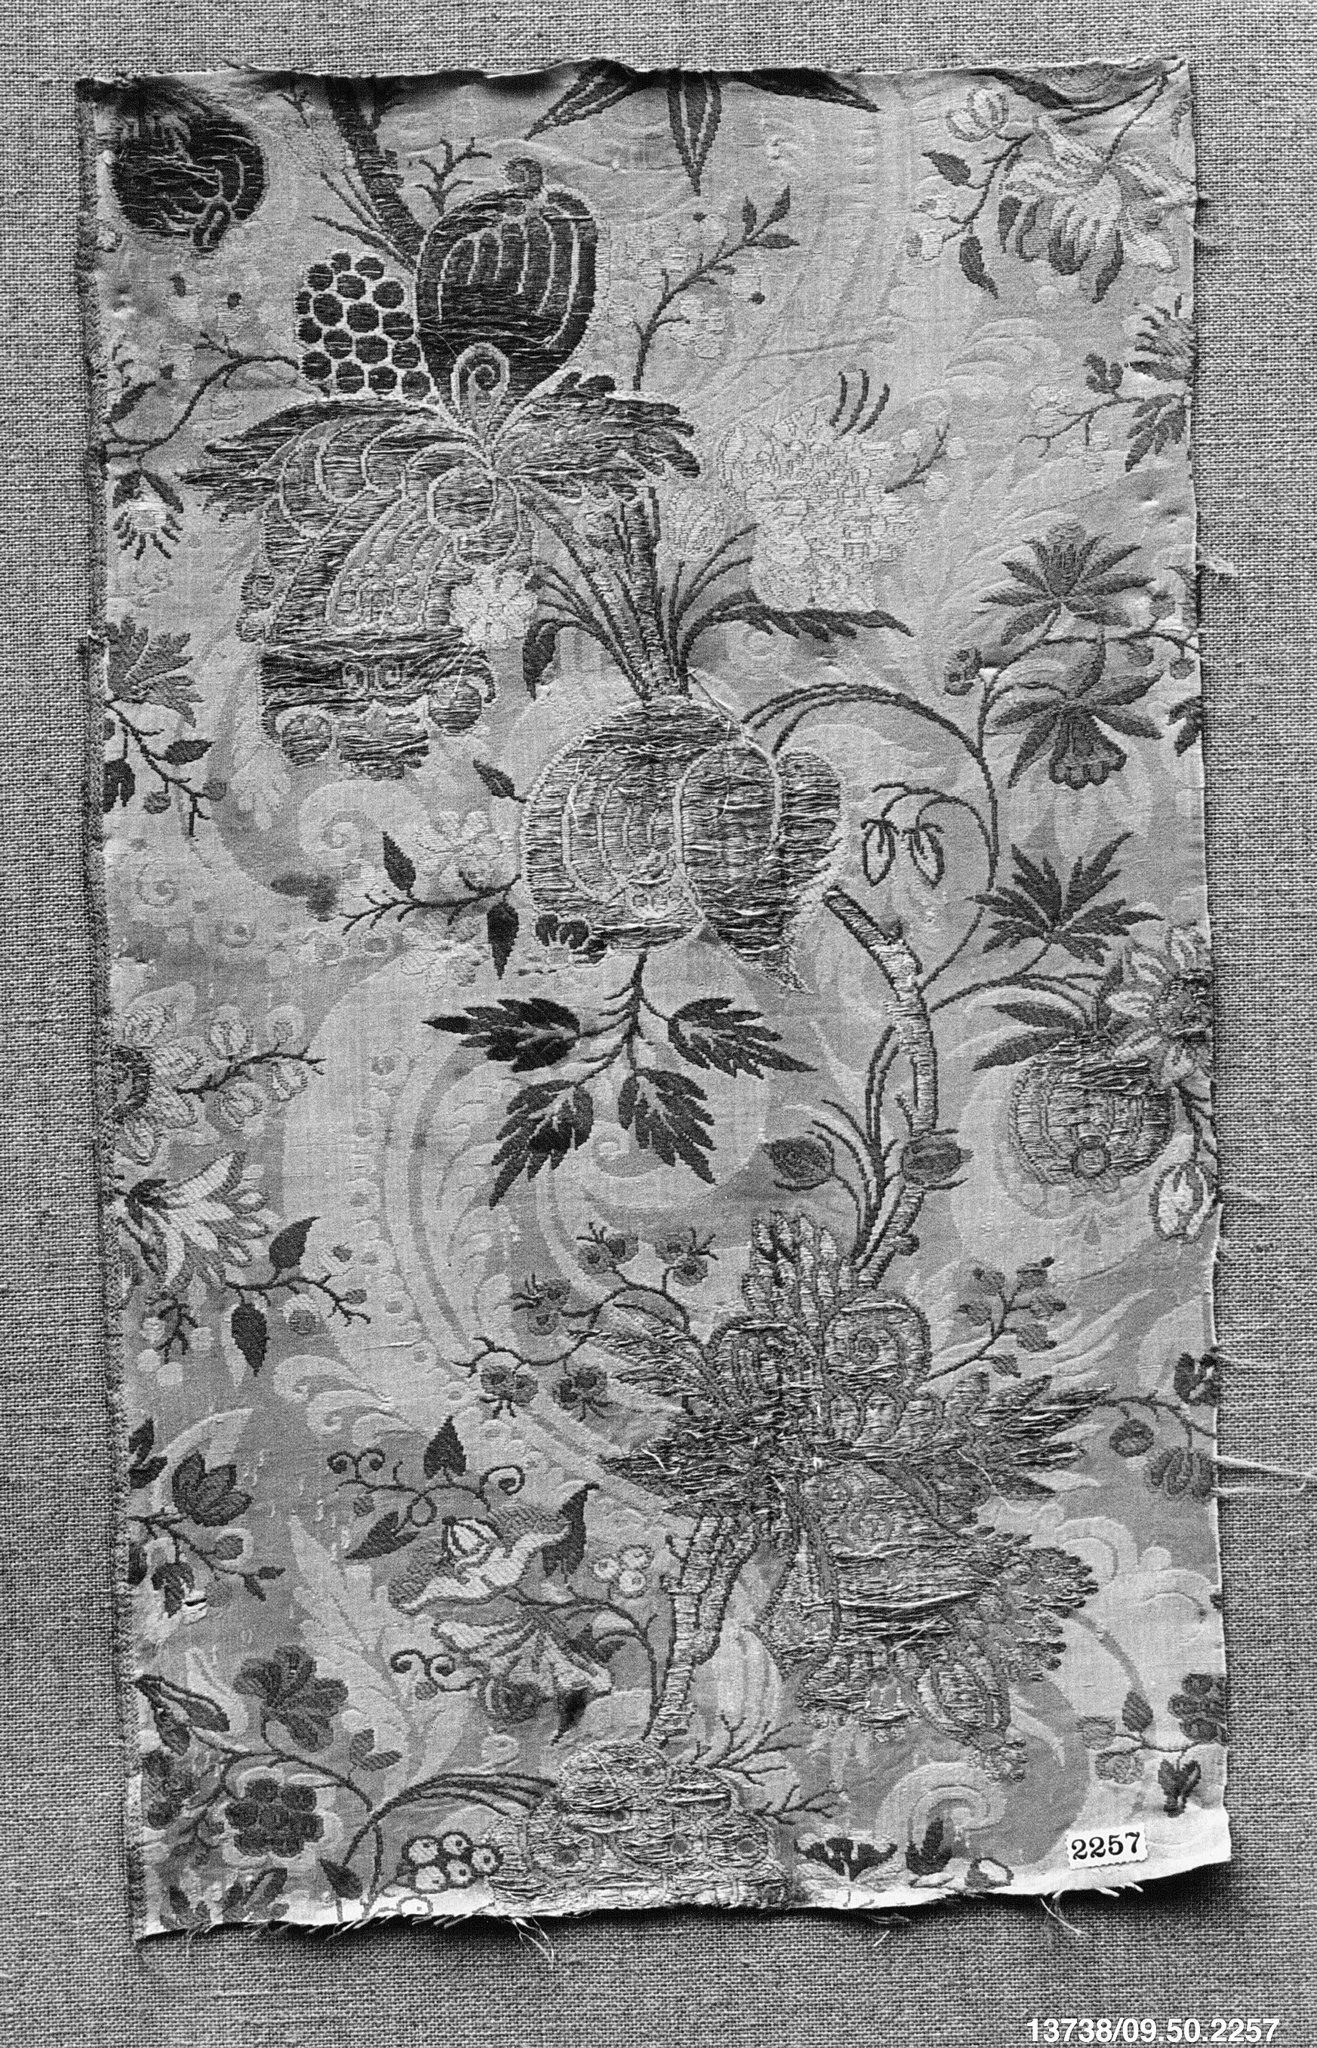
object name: piece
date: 1705-1715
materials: metal thread, silk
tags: flowers,leaves